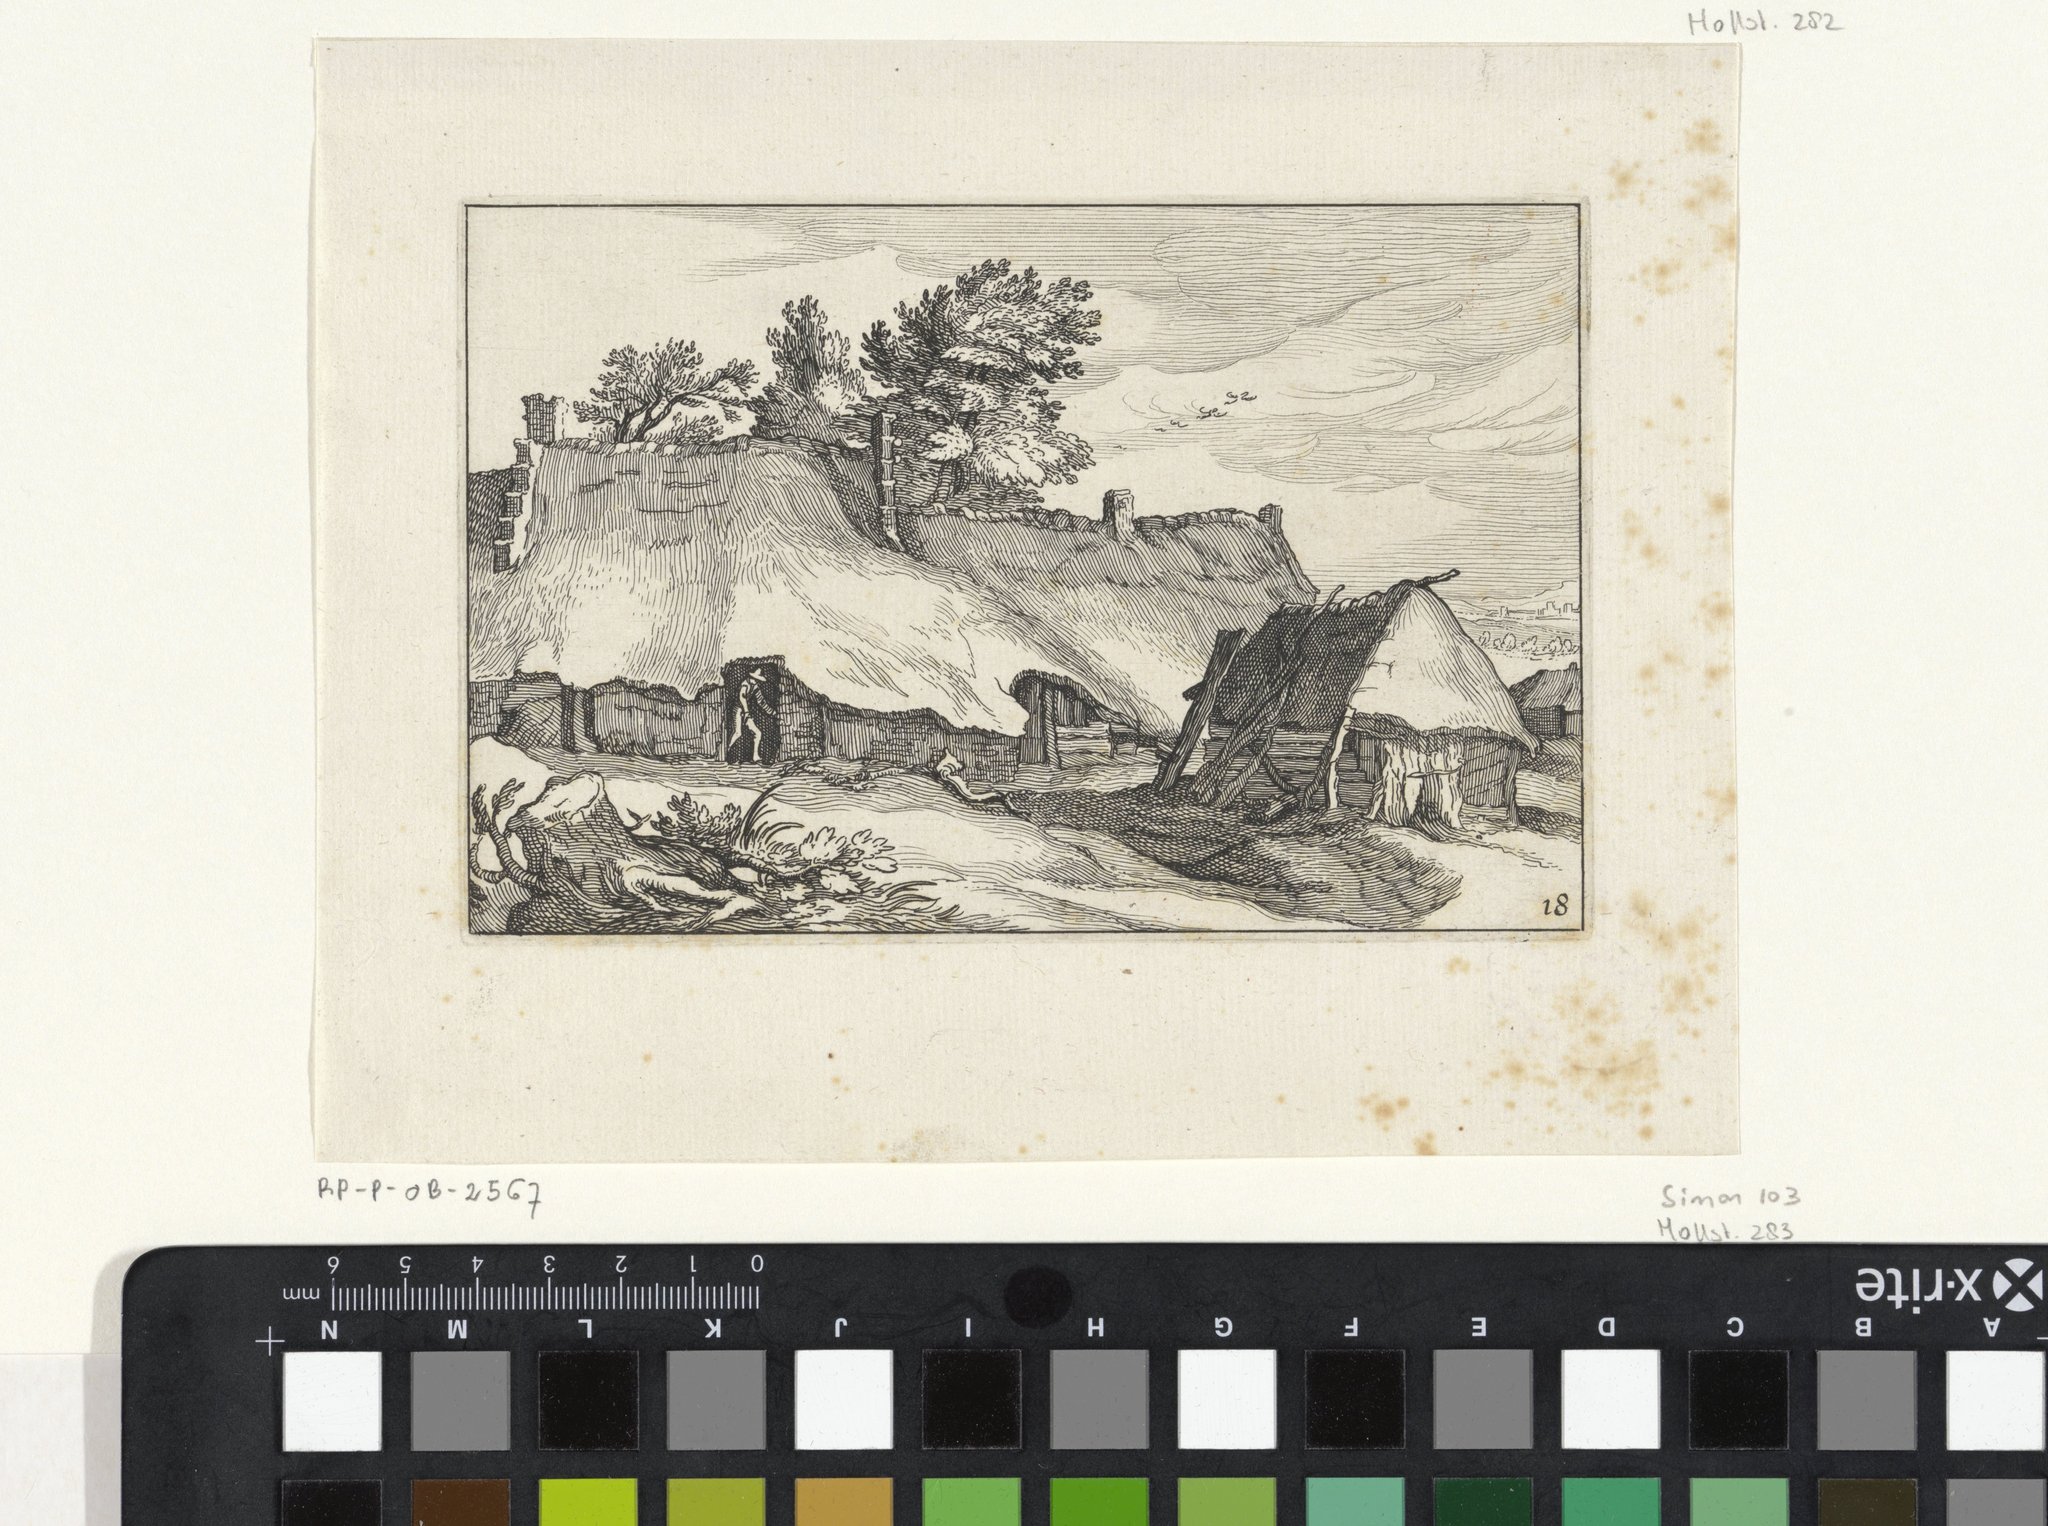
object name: print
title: Boerderij en kleine schuur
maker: claes jansz. visscher (ii)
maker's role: draughtsman, print maker, publisher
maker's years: 1586-1652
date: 1620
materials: paper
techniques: etching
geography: amsterdam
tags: landscapes, shed, farm or solitary house in landscape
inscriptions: collector's mark: Lugt 240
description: In een glooiend landschap ligt een boerderij met een kleine schuur. In de deuropening van de boerderij bevindt zich een man met een hoed.